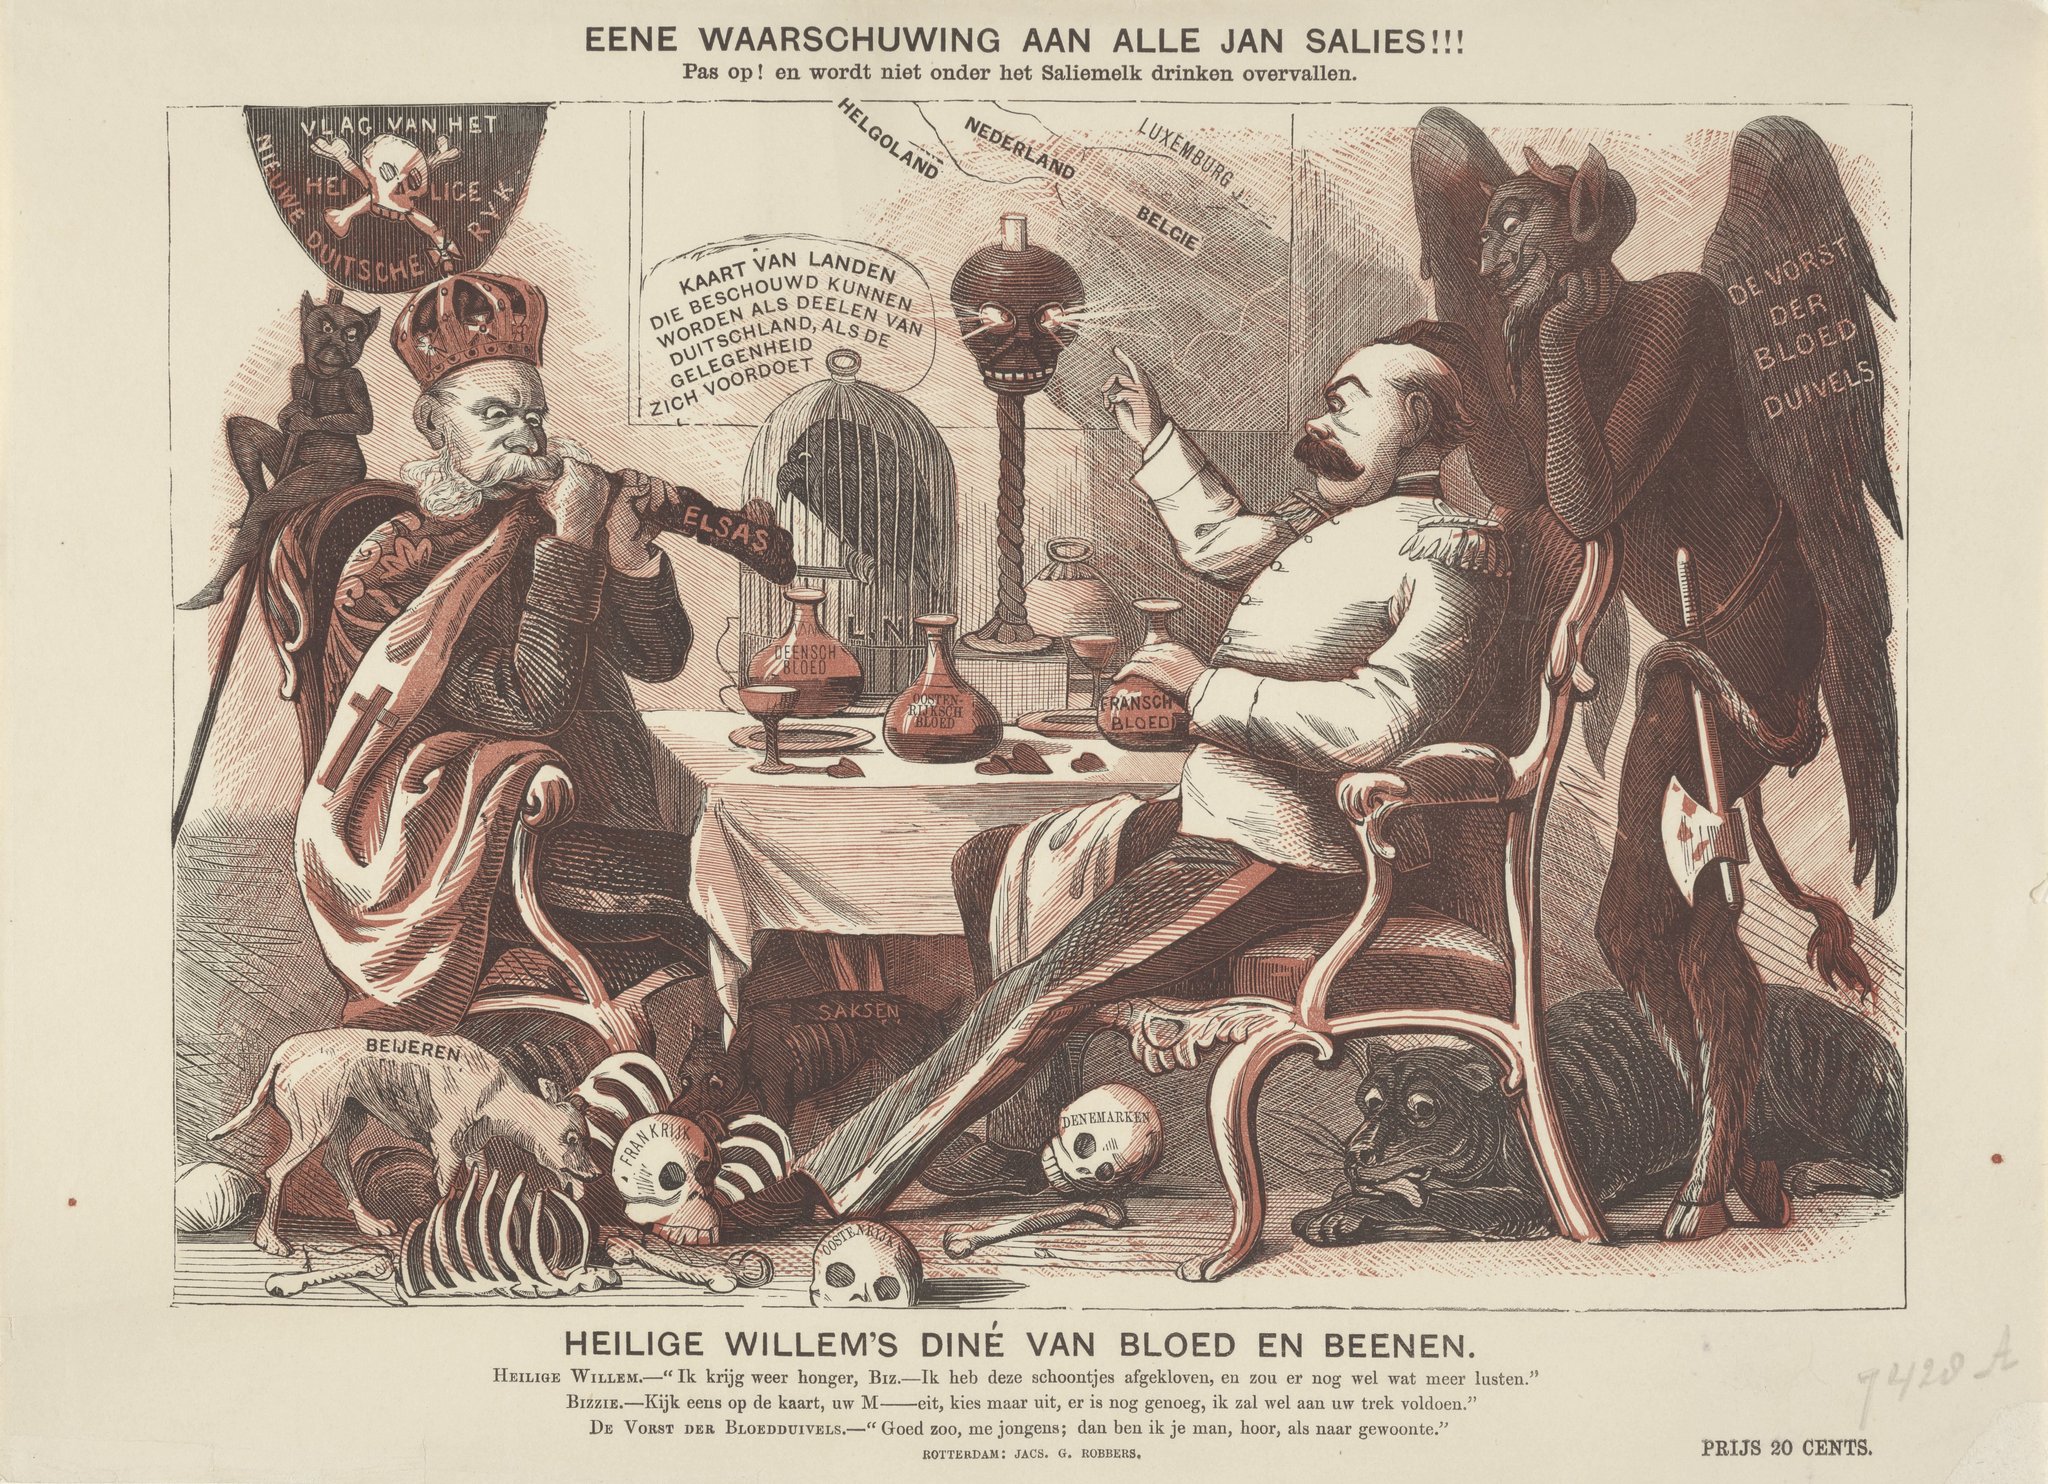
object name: print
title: Spotprent op keizer Wilhelm I en Bismarck, 1870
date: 1870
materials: paper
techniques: engraving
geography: netherlands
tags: berlin, wilhelm i (keizer van duitsland), evening meal, dinner, supper, alsace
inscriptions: collector's mark: Lugt 2228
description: Spotprent op bloeddorstigheid van keizer Wilhelm I en Otto von Bismarck, 1870. Keizer Wilhelm zit aan tafel met Bismarck aan een been 'Elsas' te kleuiven. Op tafel staan karaffen met Deens, Oostenrijks en en Frans bloed. Op de vloer liggen de schedels en botten van eerdere maaltijden. Achter de stoel van Bismarck kijkt de duivel goedkeurend toe. In het onderschrift het gesprek tussen keizer Wilhelm, Bismarck en de duivel.